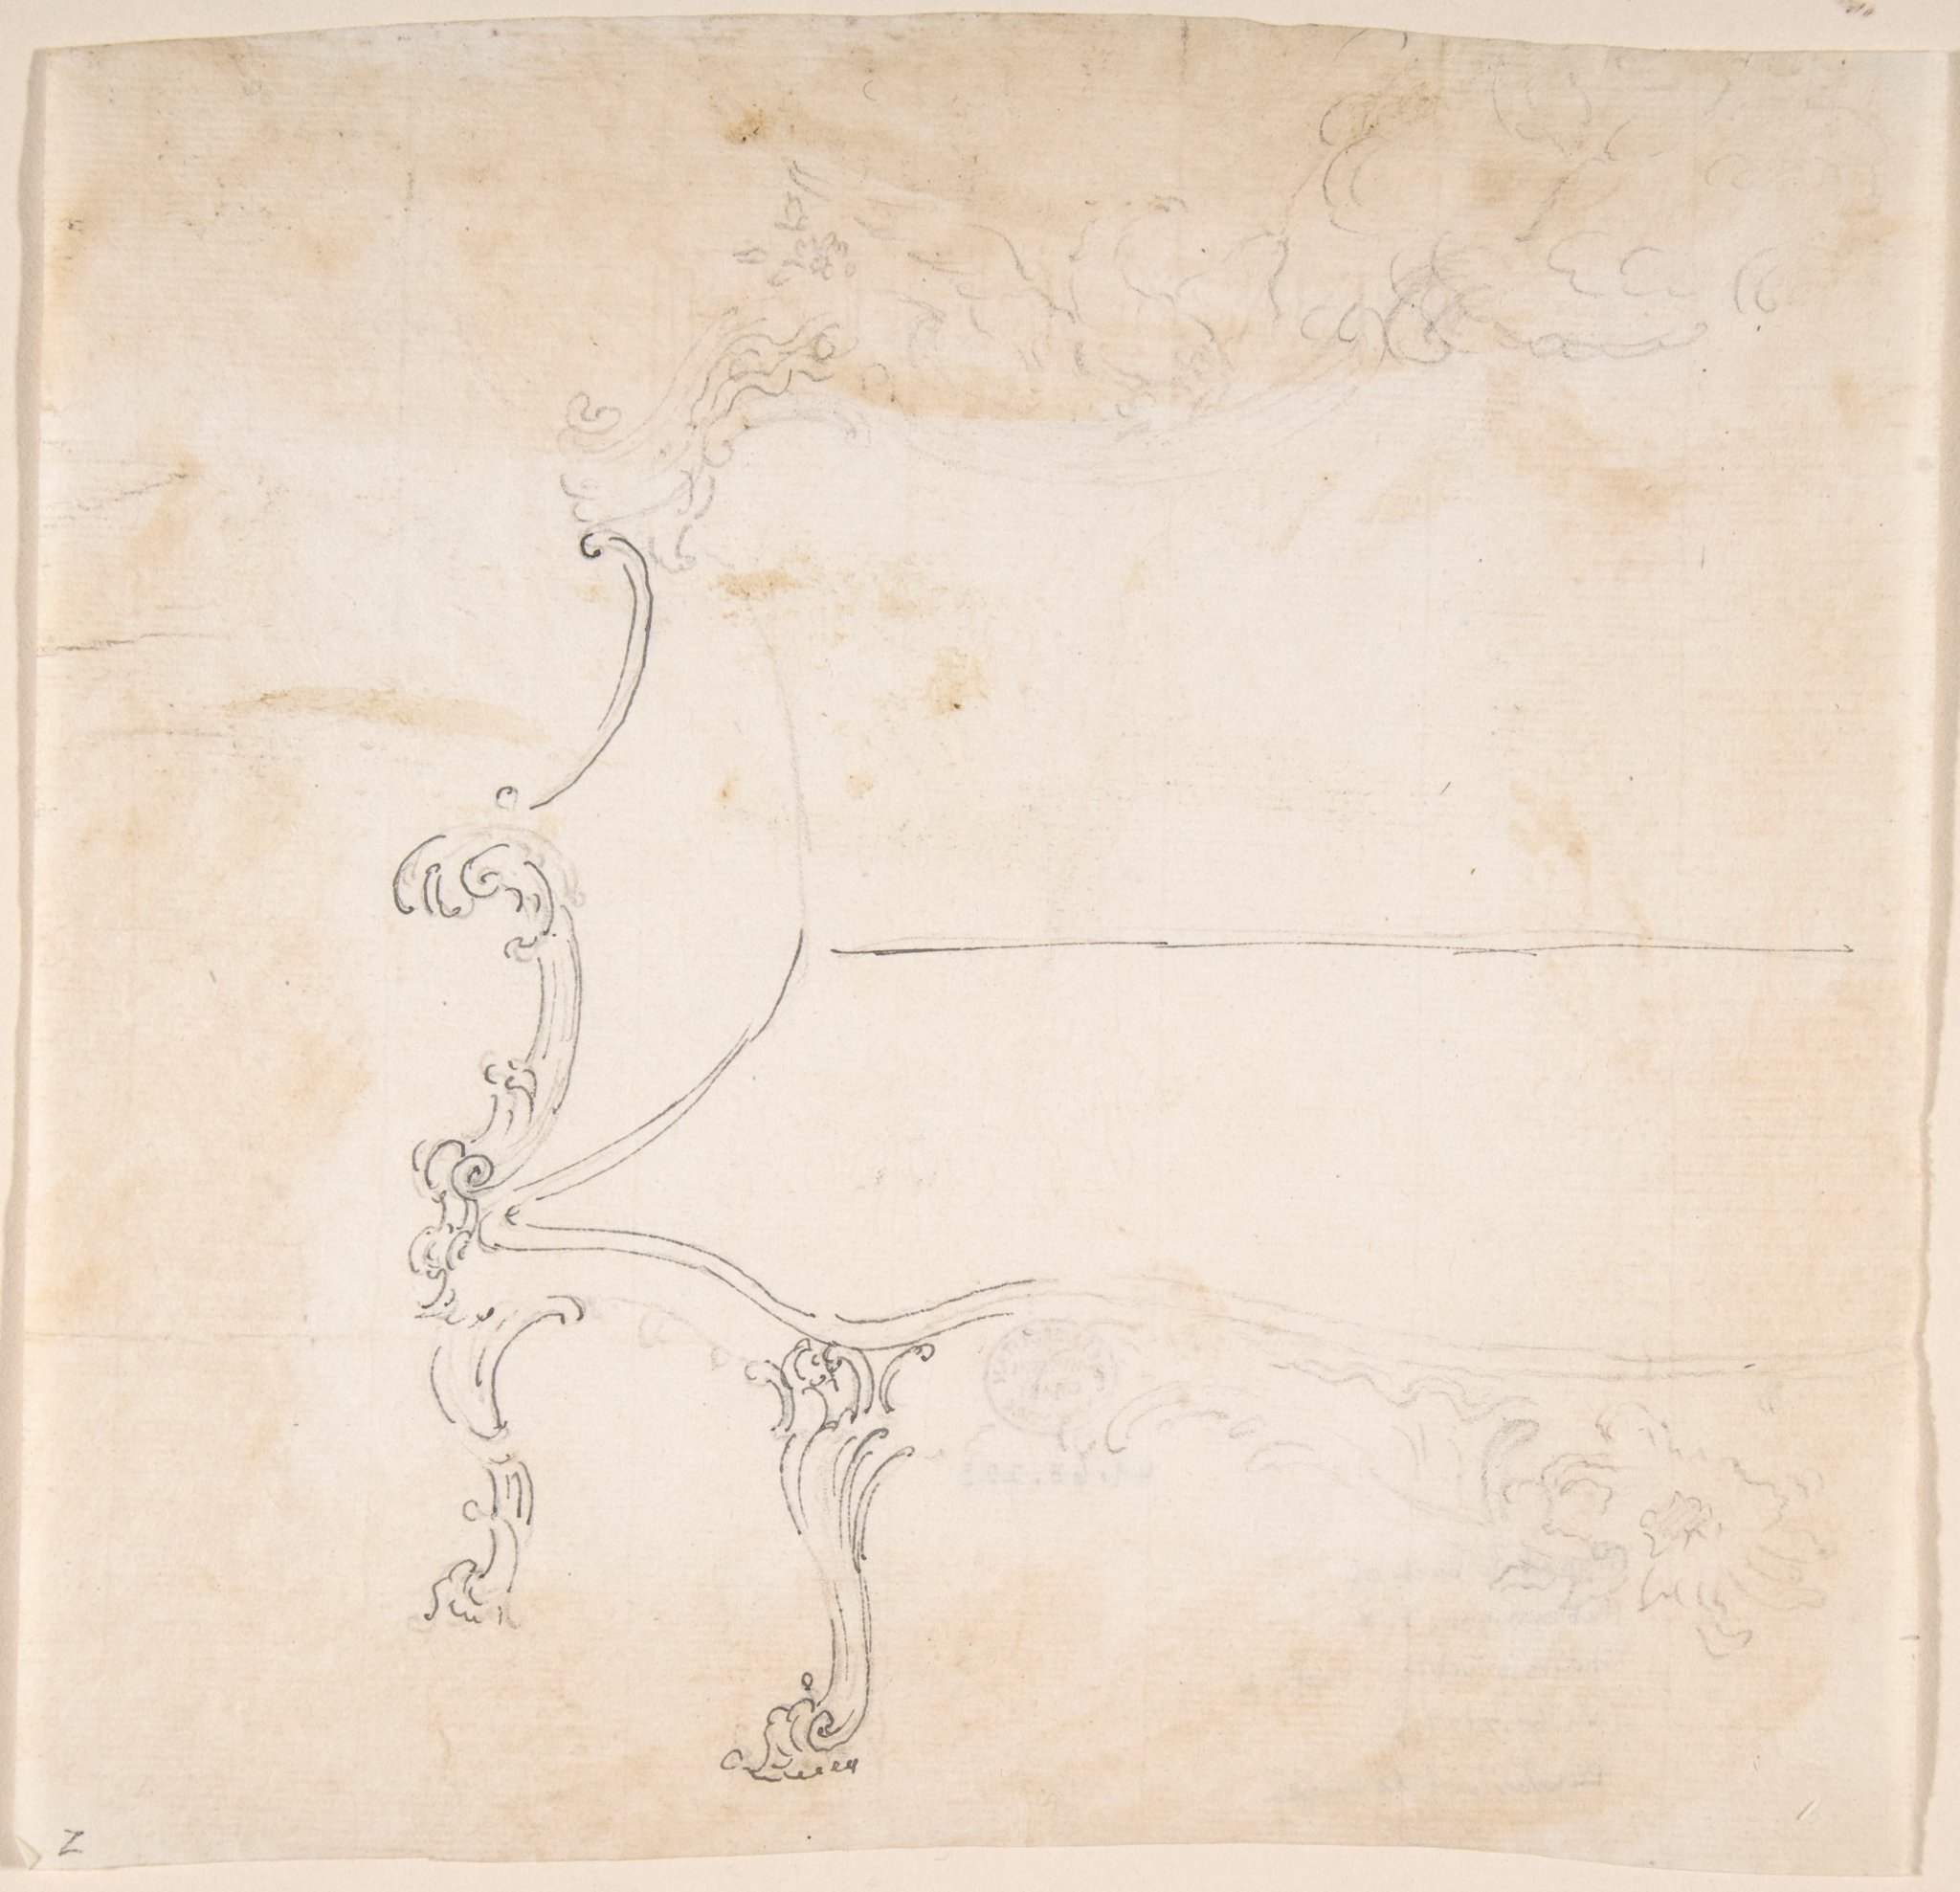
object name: drawing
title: Design for Settee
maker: anonymous, german, 18th century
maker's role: artist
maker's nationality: german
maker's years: 1700-1800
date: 1701-1800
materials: graphite, ink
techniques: pen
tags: furniture